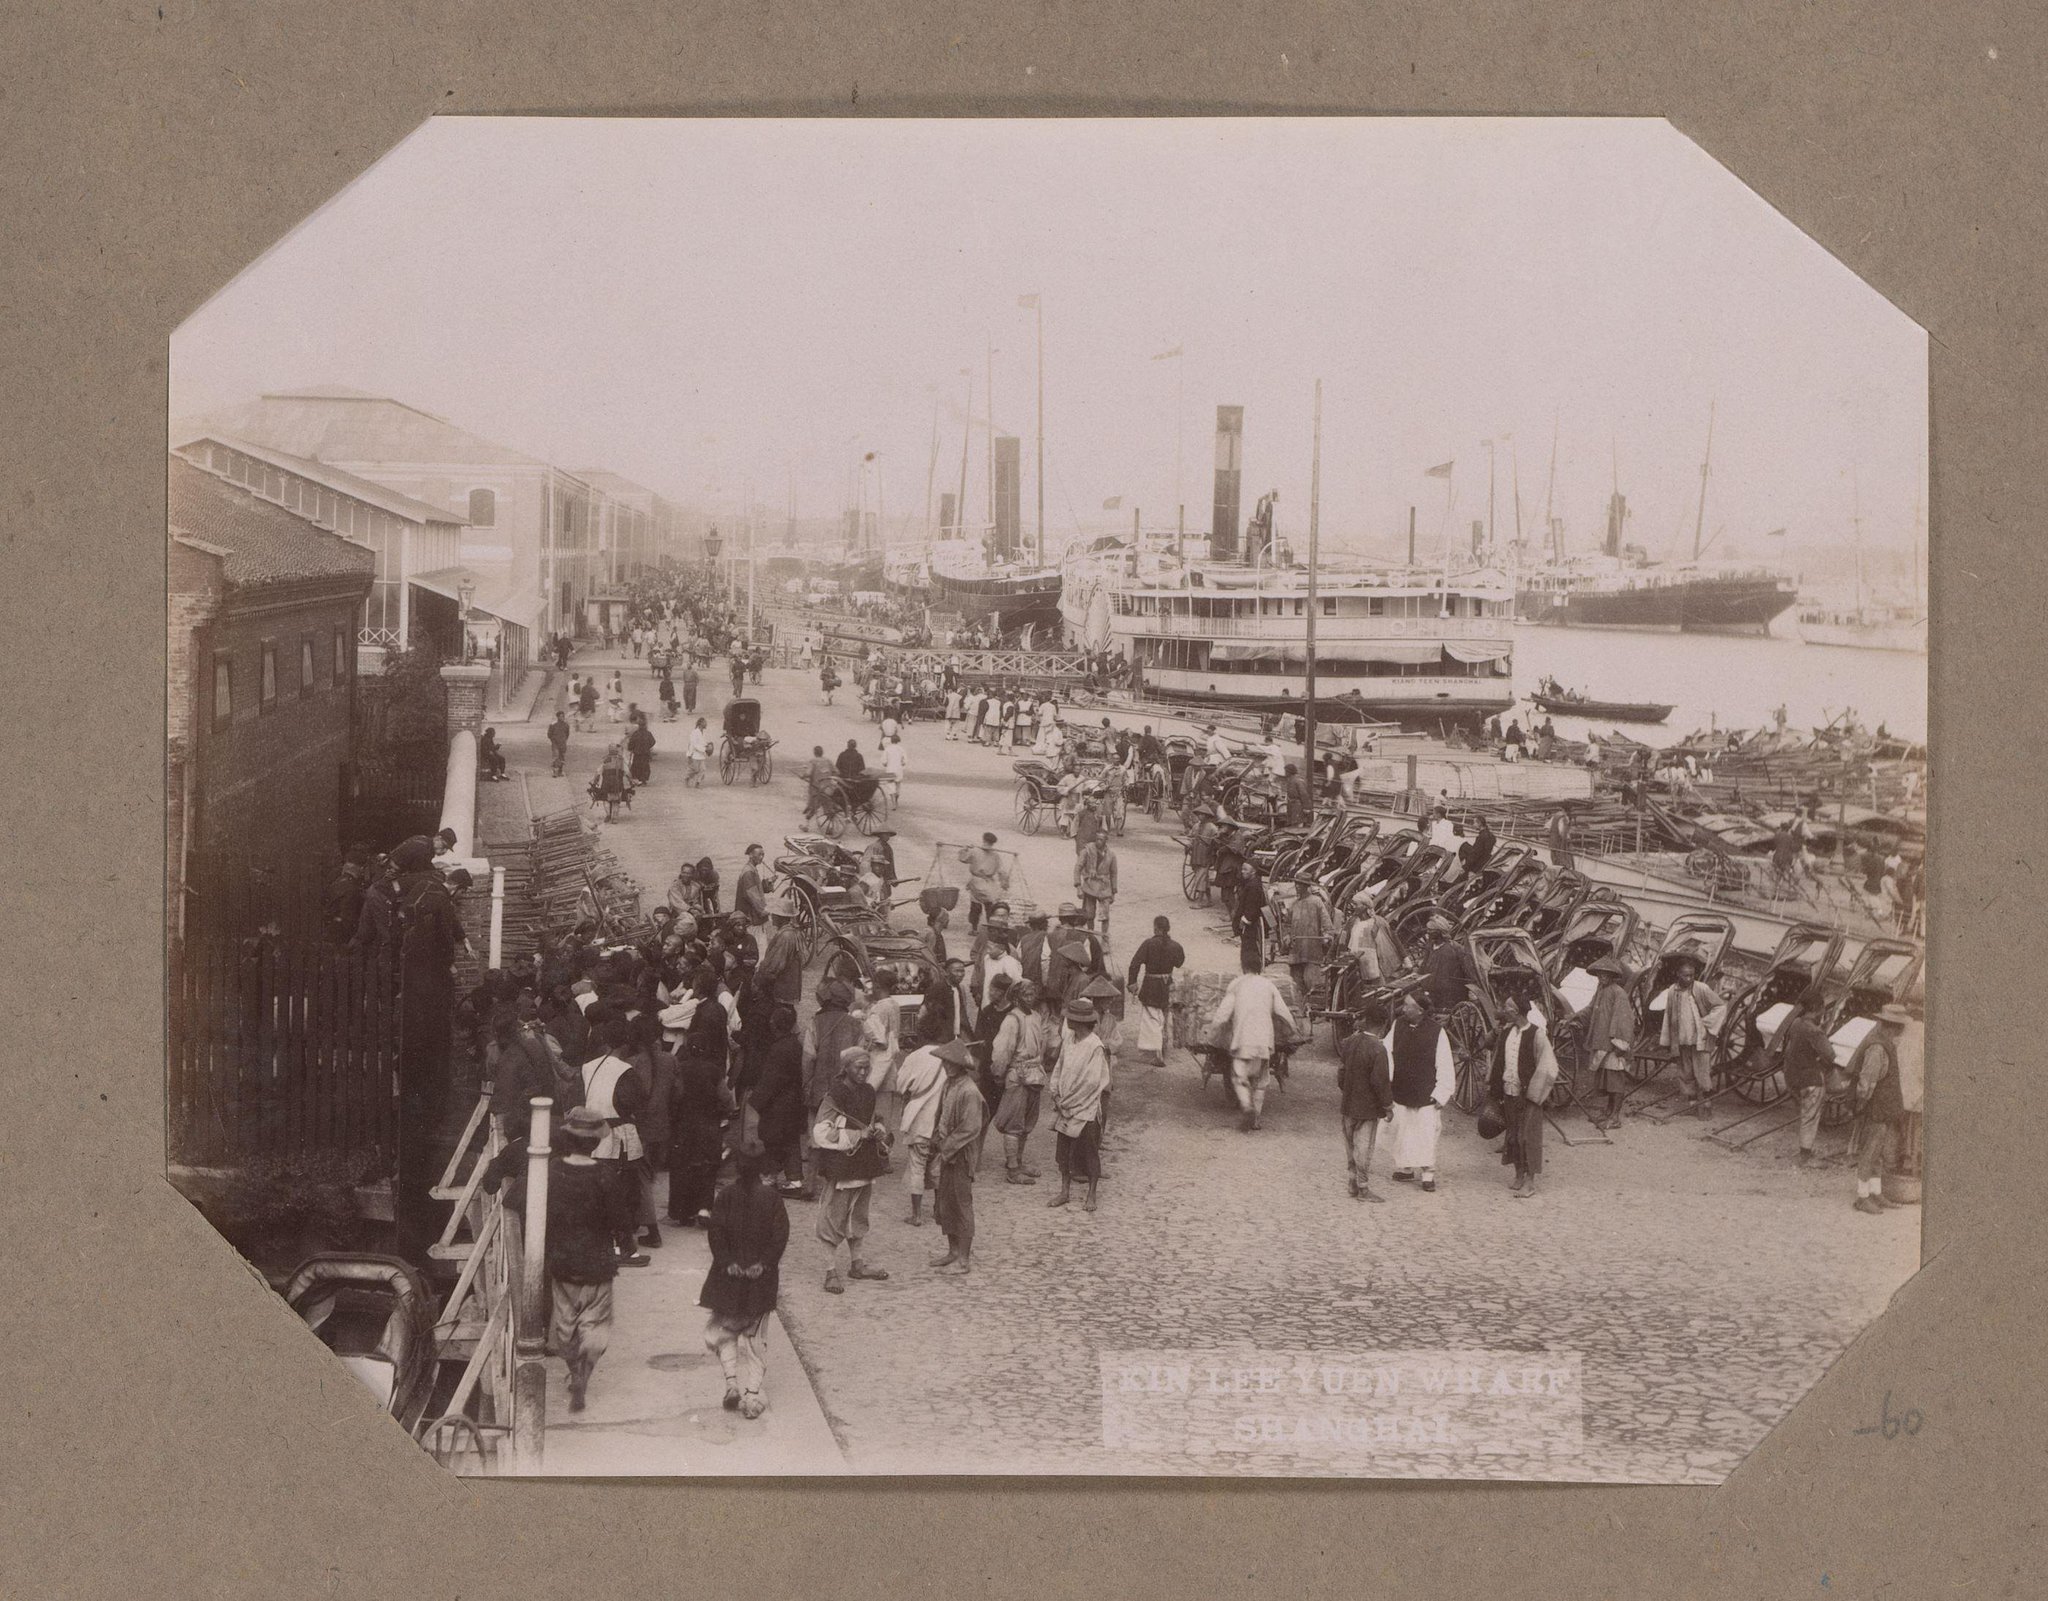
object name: album leaf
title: Riksja's op de Kin Lee Yuen werf in Shanghai, China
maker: Anonymous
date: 1890-1903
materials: paper, photographic support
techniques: albumen print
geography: shanghai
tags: rickshaw, pier, quay, wharf, street (+ city(-scape) with figures, staffage)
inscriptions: inscription: ‘Kin Lee Yuen Wharf / Shanghai’